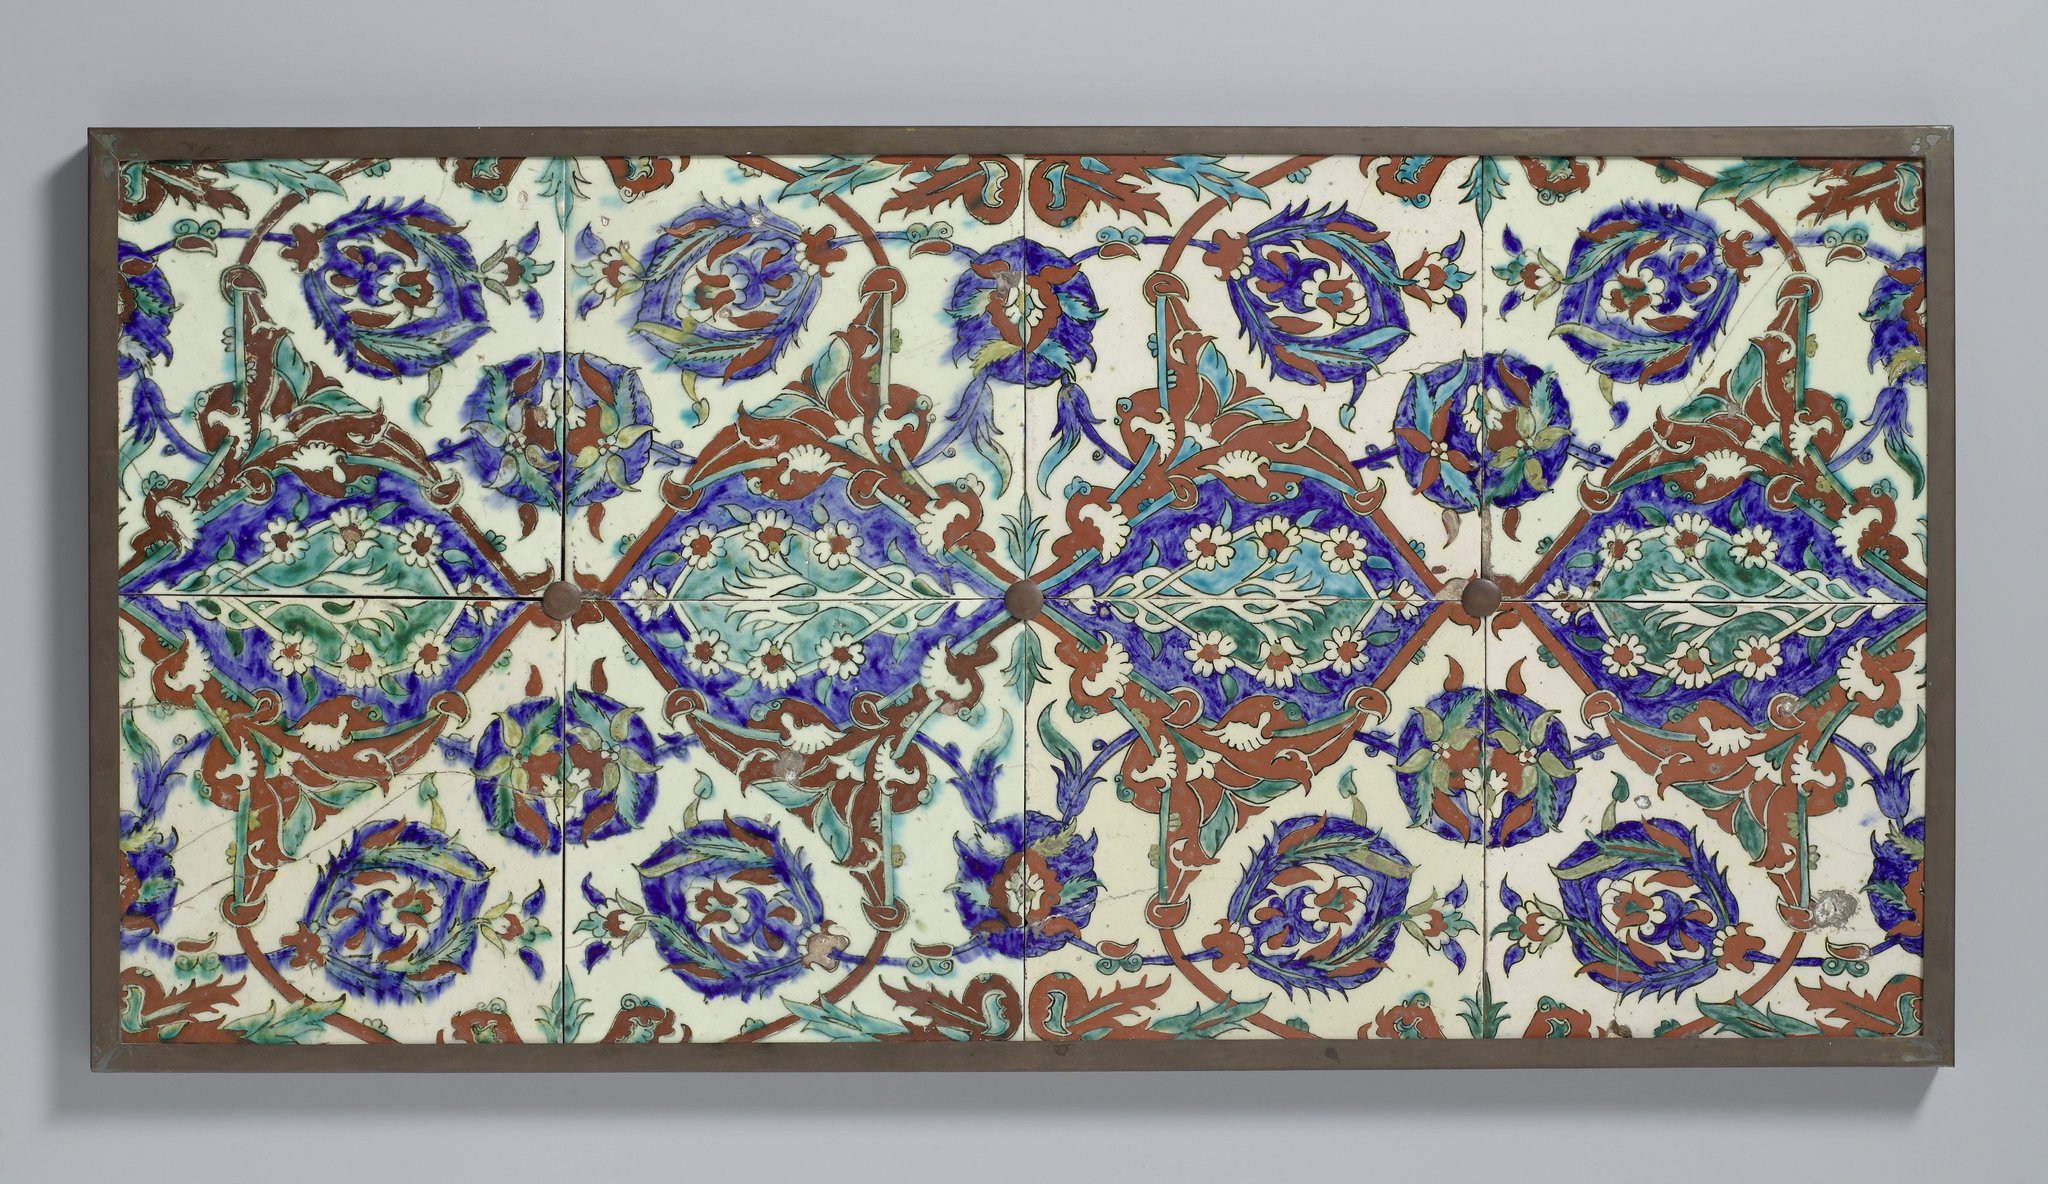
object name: tile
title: Eight tiles with a continuous pattern of floral scrolls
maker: Anonymous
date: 1800-1899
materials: earthenware, glaze, paint, quartz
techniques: firing, forming, vitrification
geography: iznik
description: Tegelveld van acht grote bij elkaar behorende tegels, beschilderd in blauw, rood en groen met een doorlopend patroon van bloemranken.